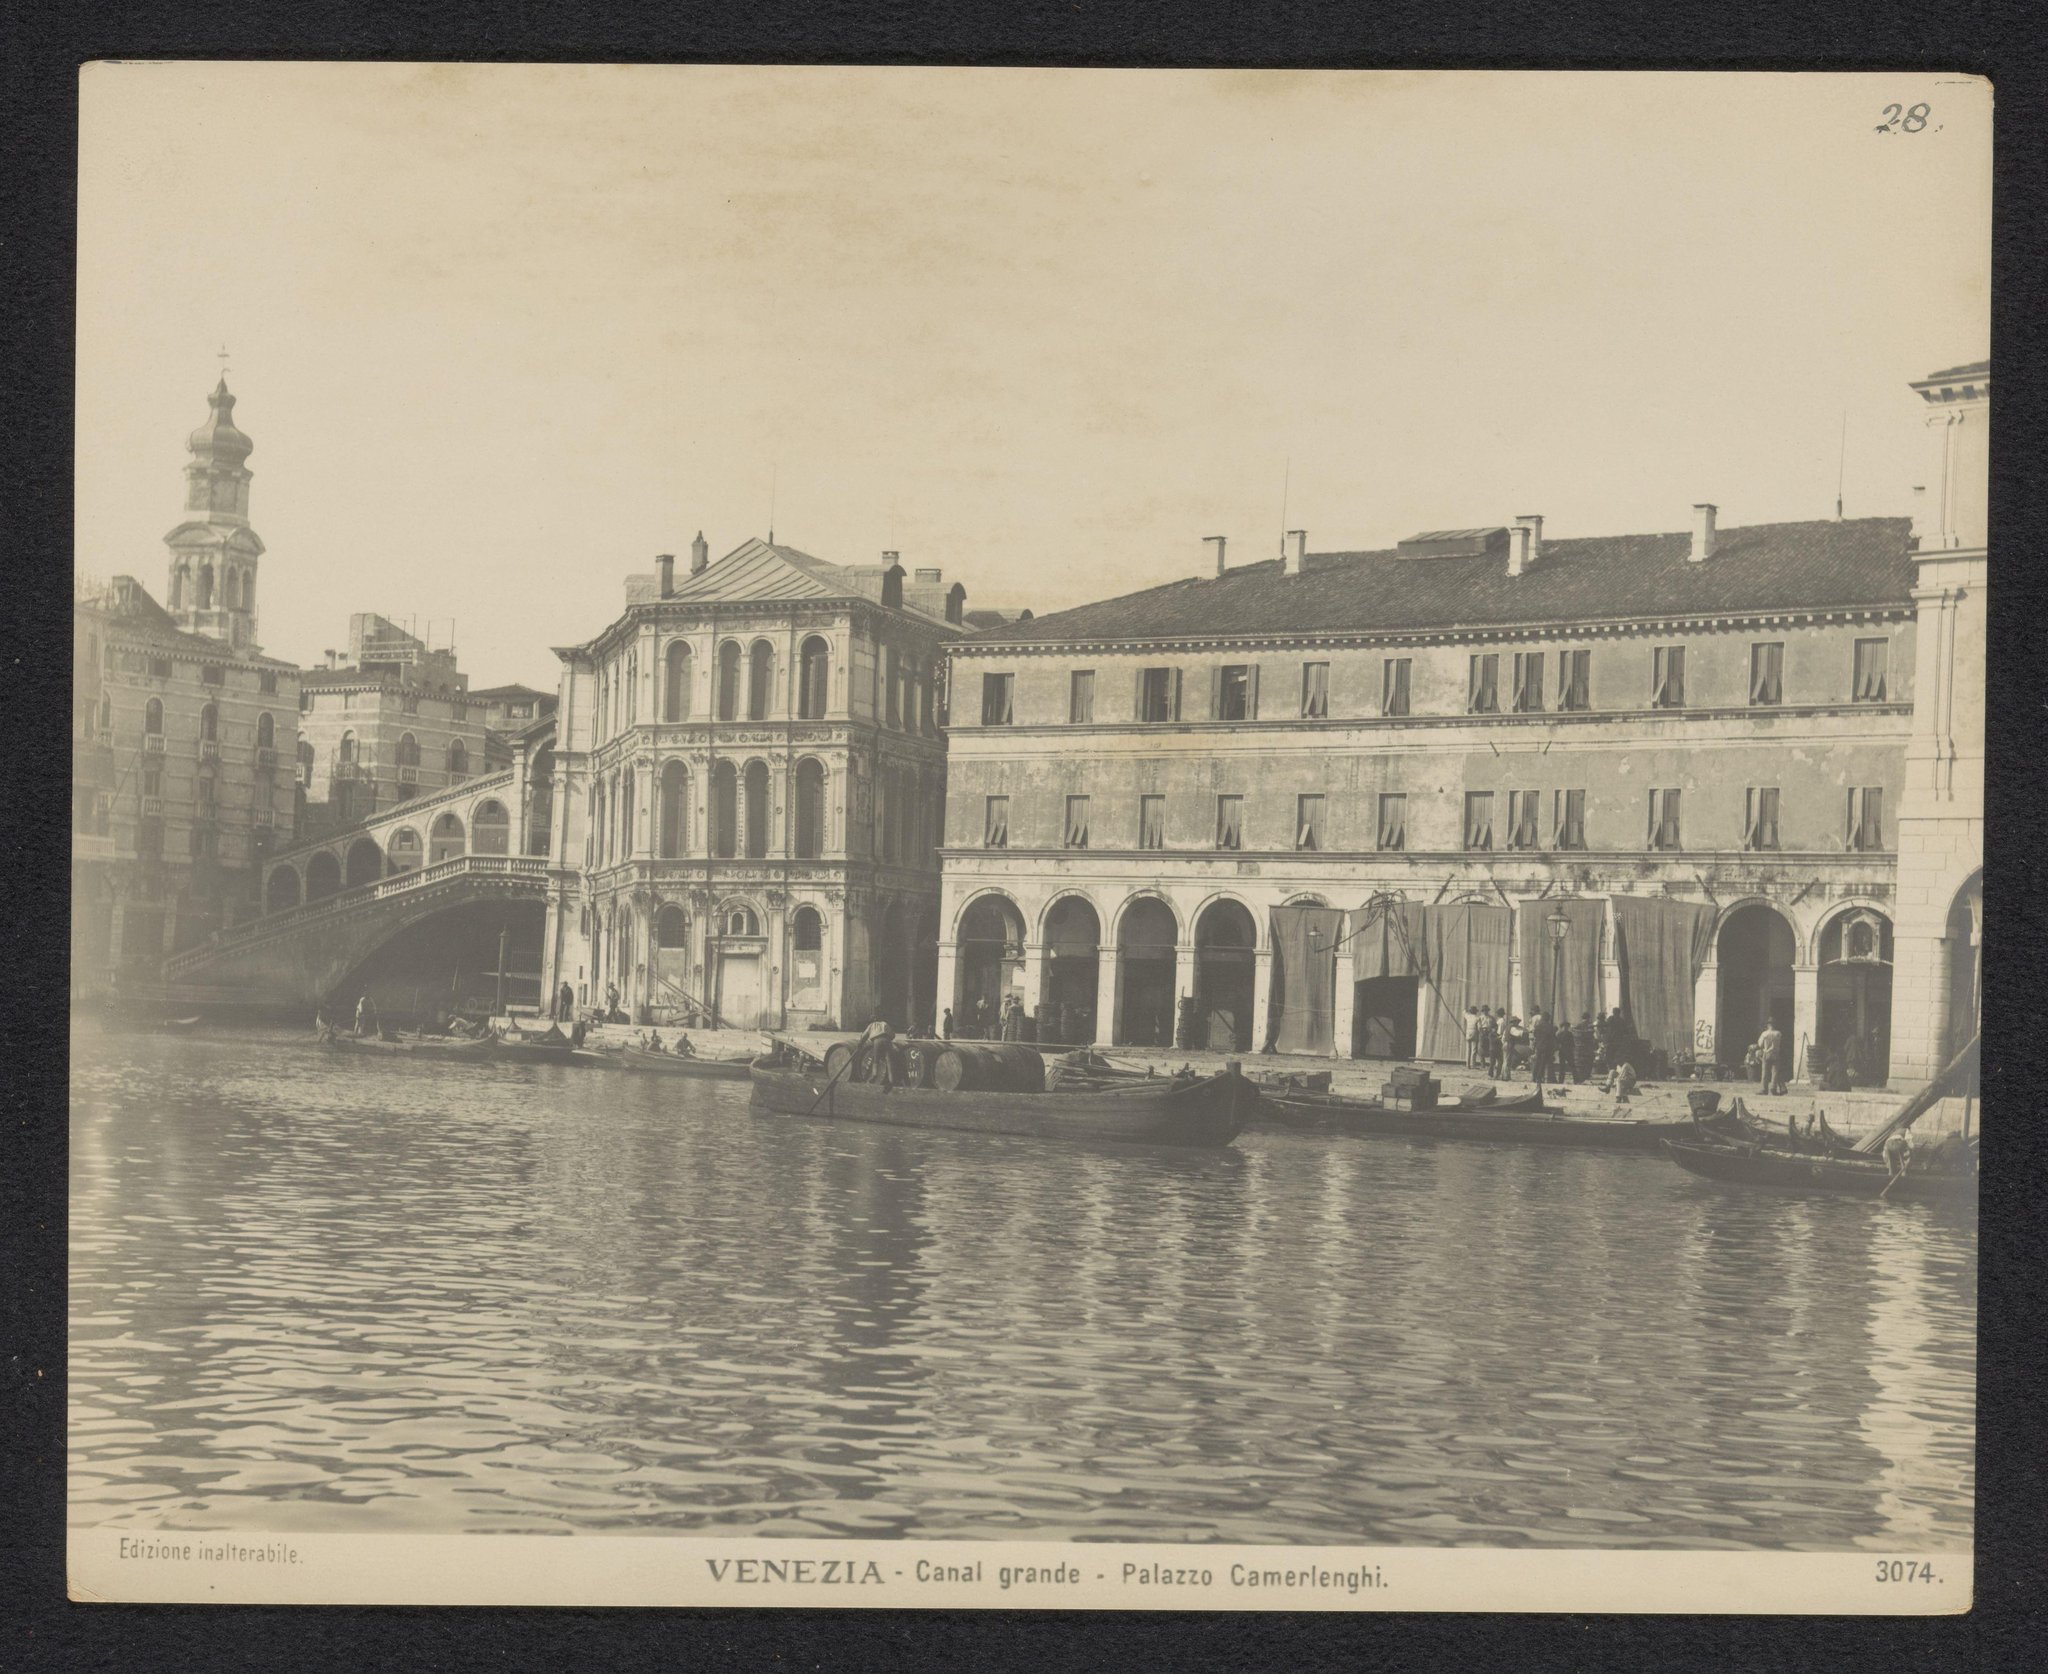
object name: photograph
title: Gezicht op het Palazzo dei Camerlenghi te Venetië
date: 1900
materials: cardboard, photographic support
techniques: gelatin silver print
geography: venice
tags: canal, hôtel, i.e. small palace in city, gondola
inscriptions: number: ‘3074’, number: ‘28.’